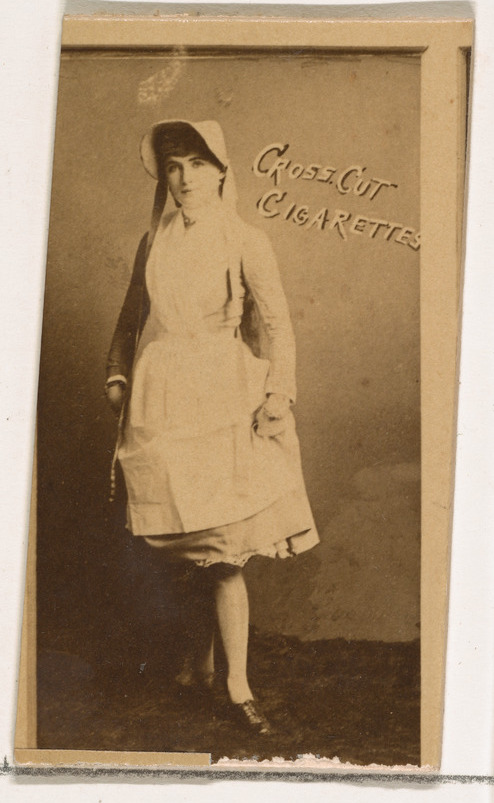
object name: print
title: Unknown actress in white cap and apron, from the Actors and Actresses series (N145-1) issued by Duke Sons & Co. to promote Cross Cut Cigarettes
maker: w. duke, sons & co.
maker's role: publisher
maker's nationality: american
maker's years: 1870-1920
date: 1880-1889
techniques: albumen silver print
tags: portraits,women,actresses